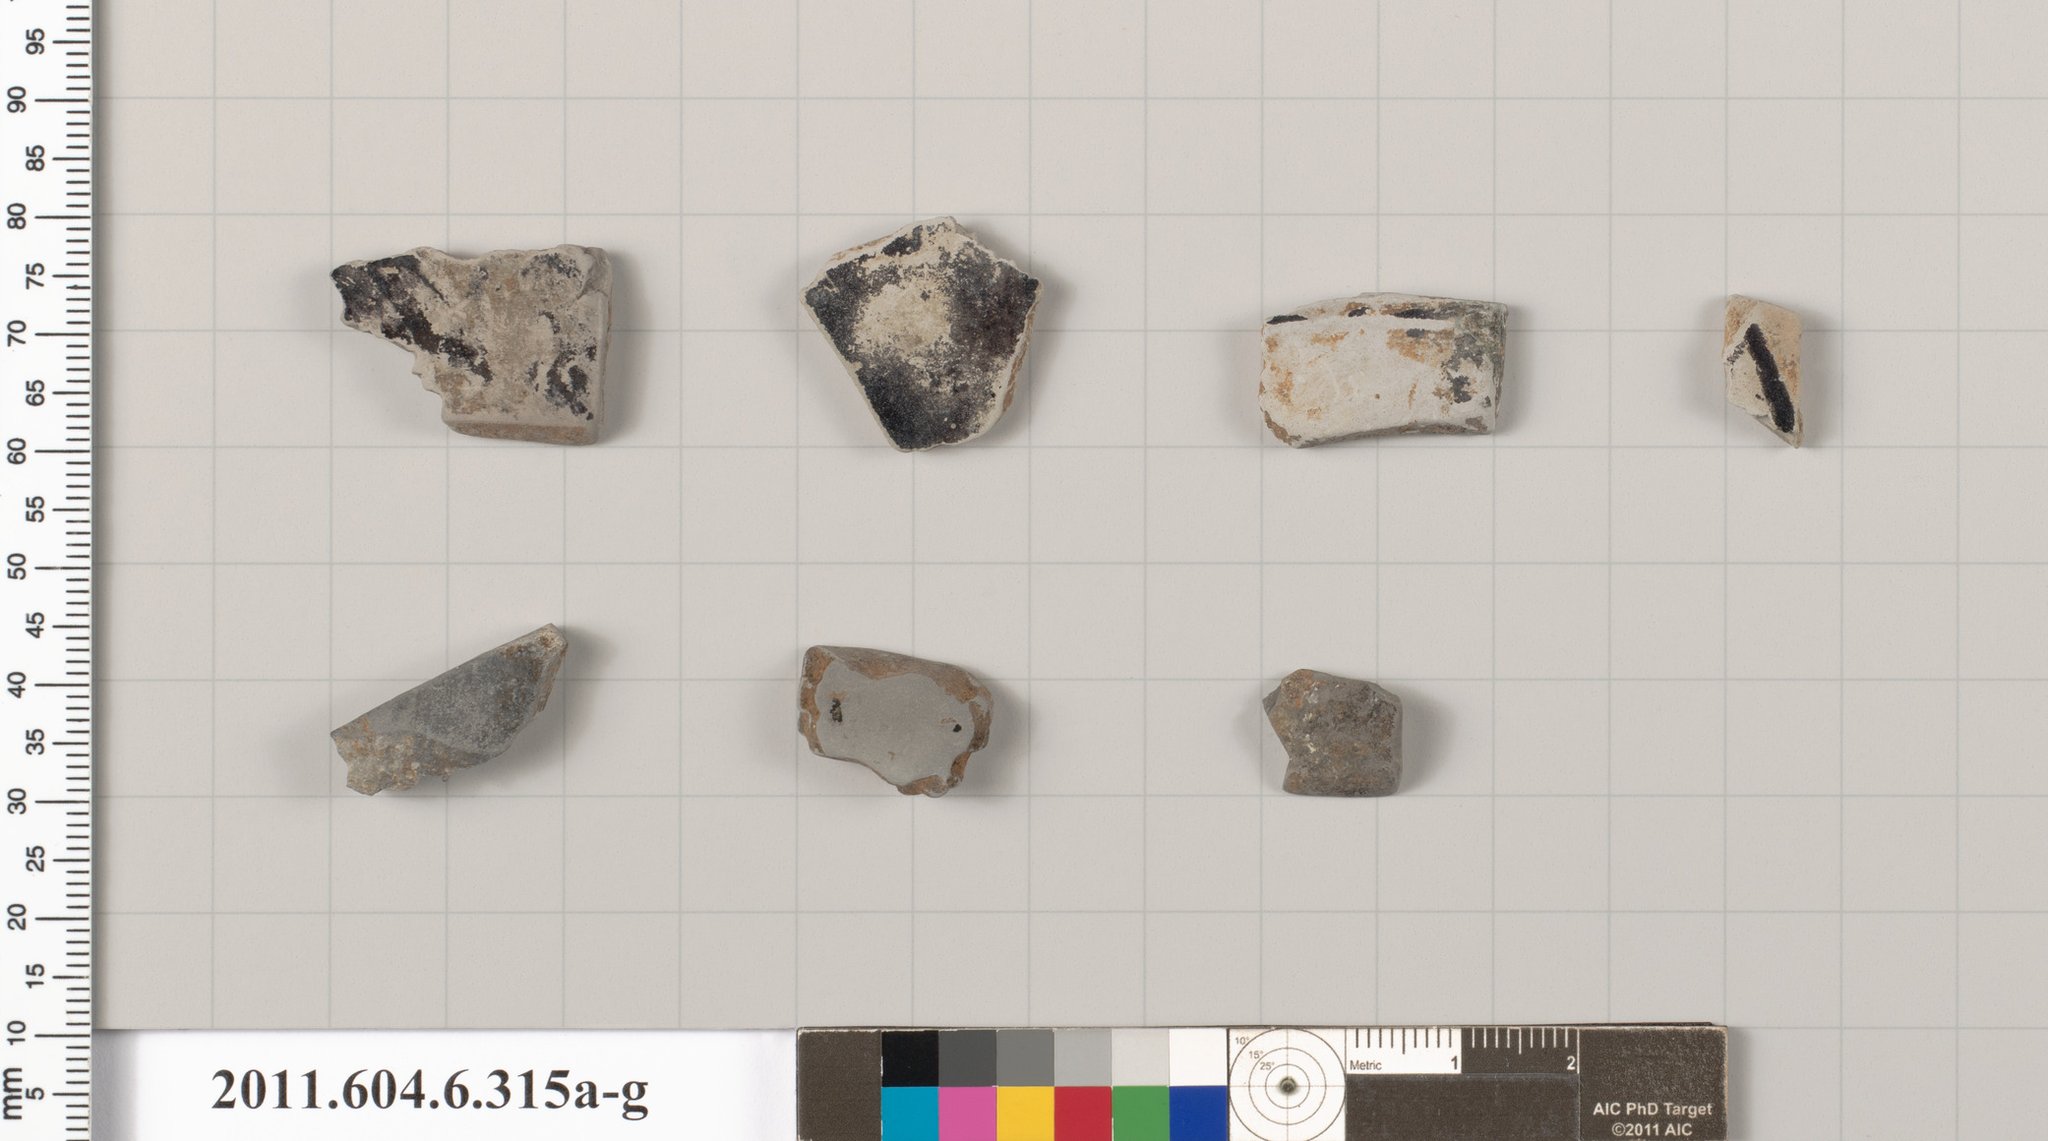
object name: undetermined shape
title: Terracotta fragments of undetermined shapes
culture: greek, attic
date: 600-401 BCE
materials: terracotta